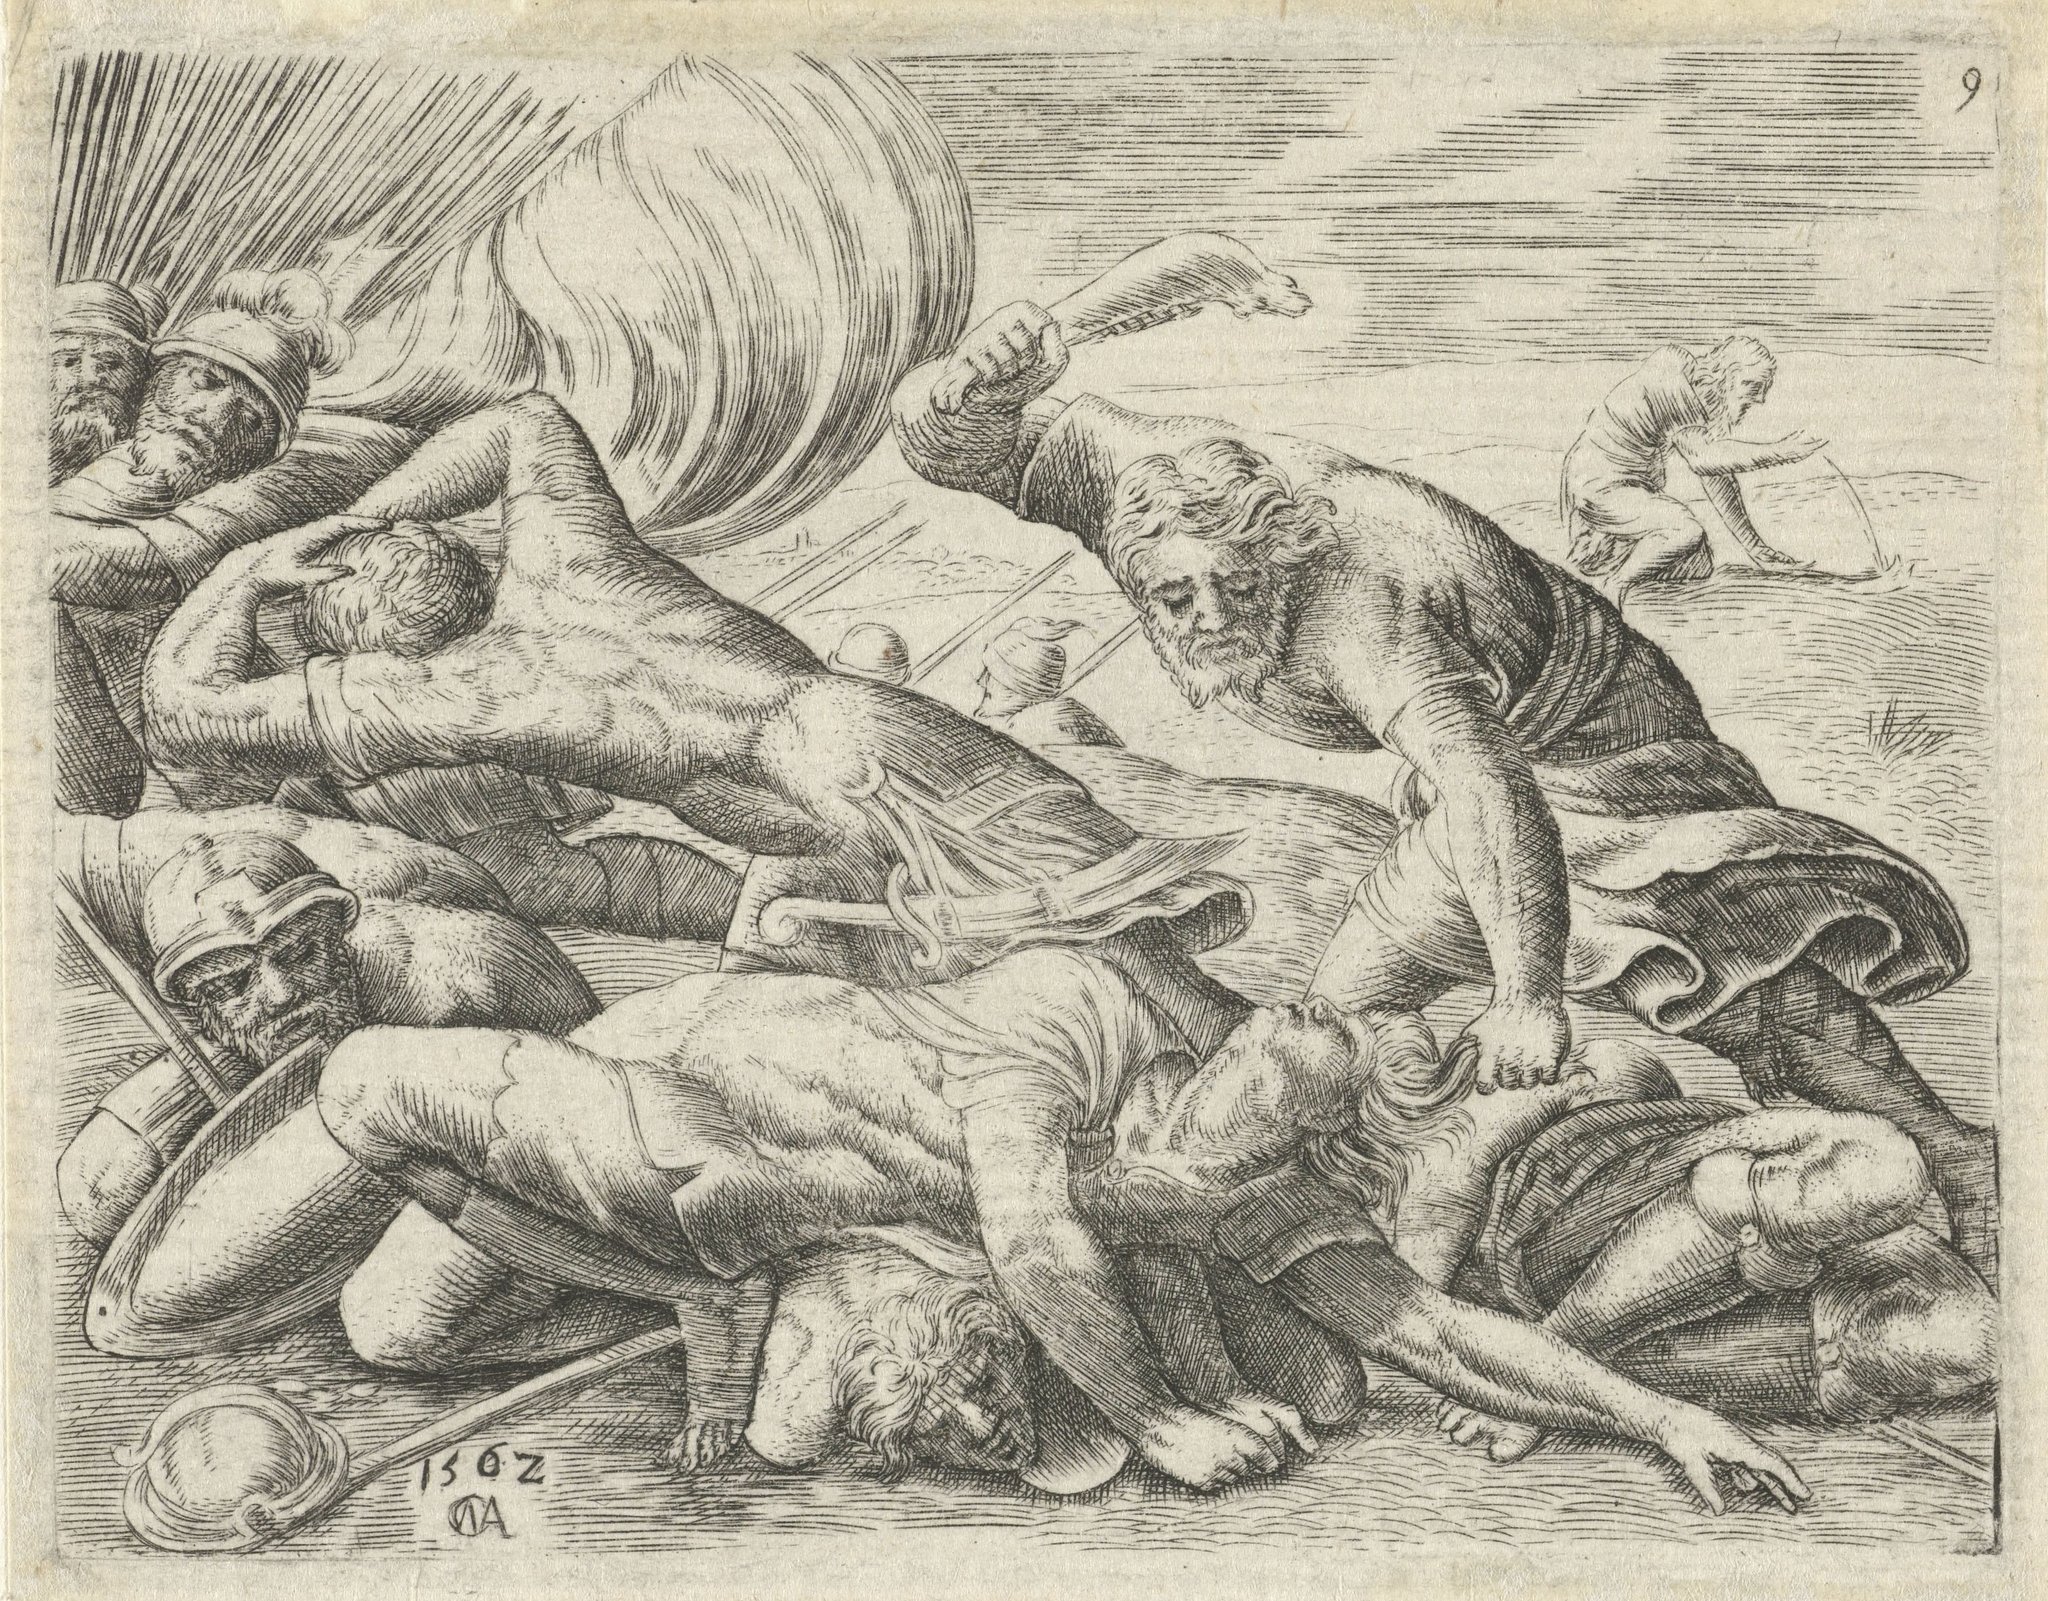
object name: print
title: Simson verslaat de Filistijnen met een ezelskaak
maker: cornelis massijs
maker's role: painter, print maker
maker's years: 1510-1557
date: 1562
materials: paper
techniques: engraving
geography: antwerp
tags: with an ass's jaw-bone samson slays a thousand philistines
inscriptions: collector's mark: Lugt 2542, collector's mark: Lugt 2228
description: Simson slaat met het kaakbeen van een ezel de Filistijnen dood. Op de achtergrond stroomt er water uit de ezelskaak, waarvan Simson drinkt. (De juiste lezing is God in de kom van het dal bij Lechi de aarde liet openbarsten. Er kwam water uit en Simson dronk ervan, zodat hij weer helemaal op krachten kwam.)